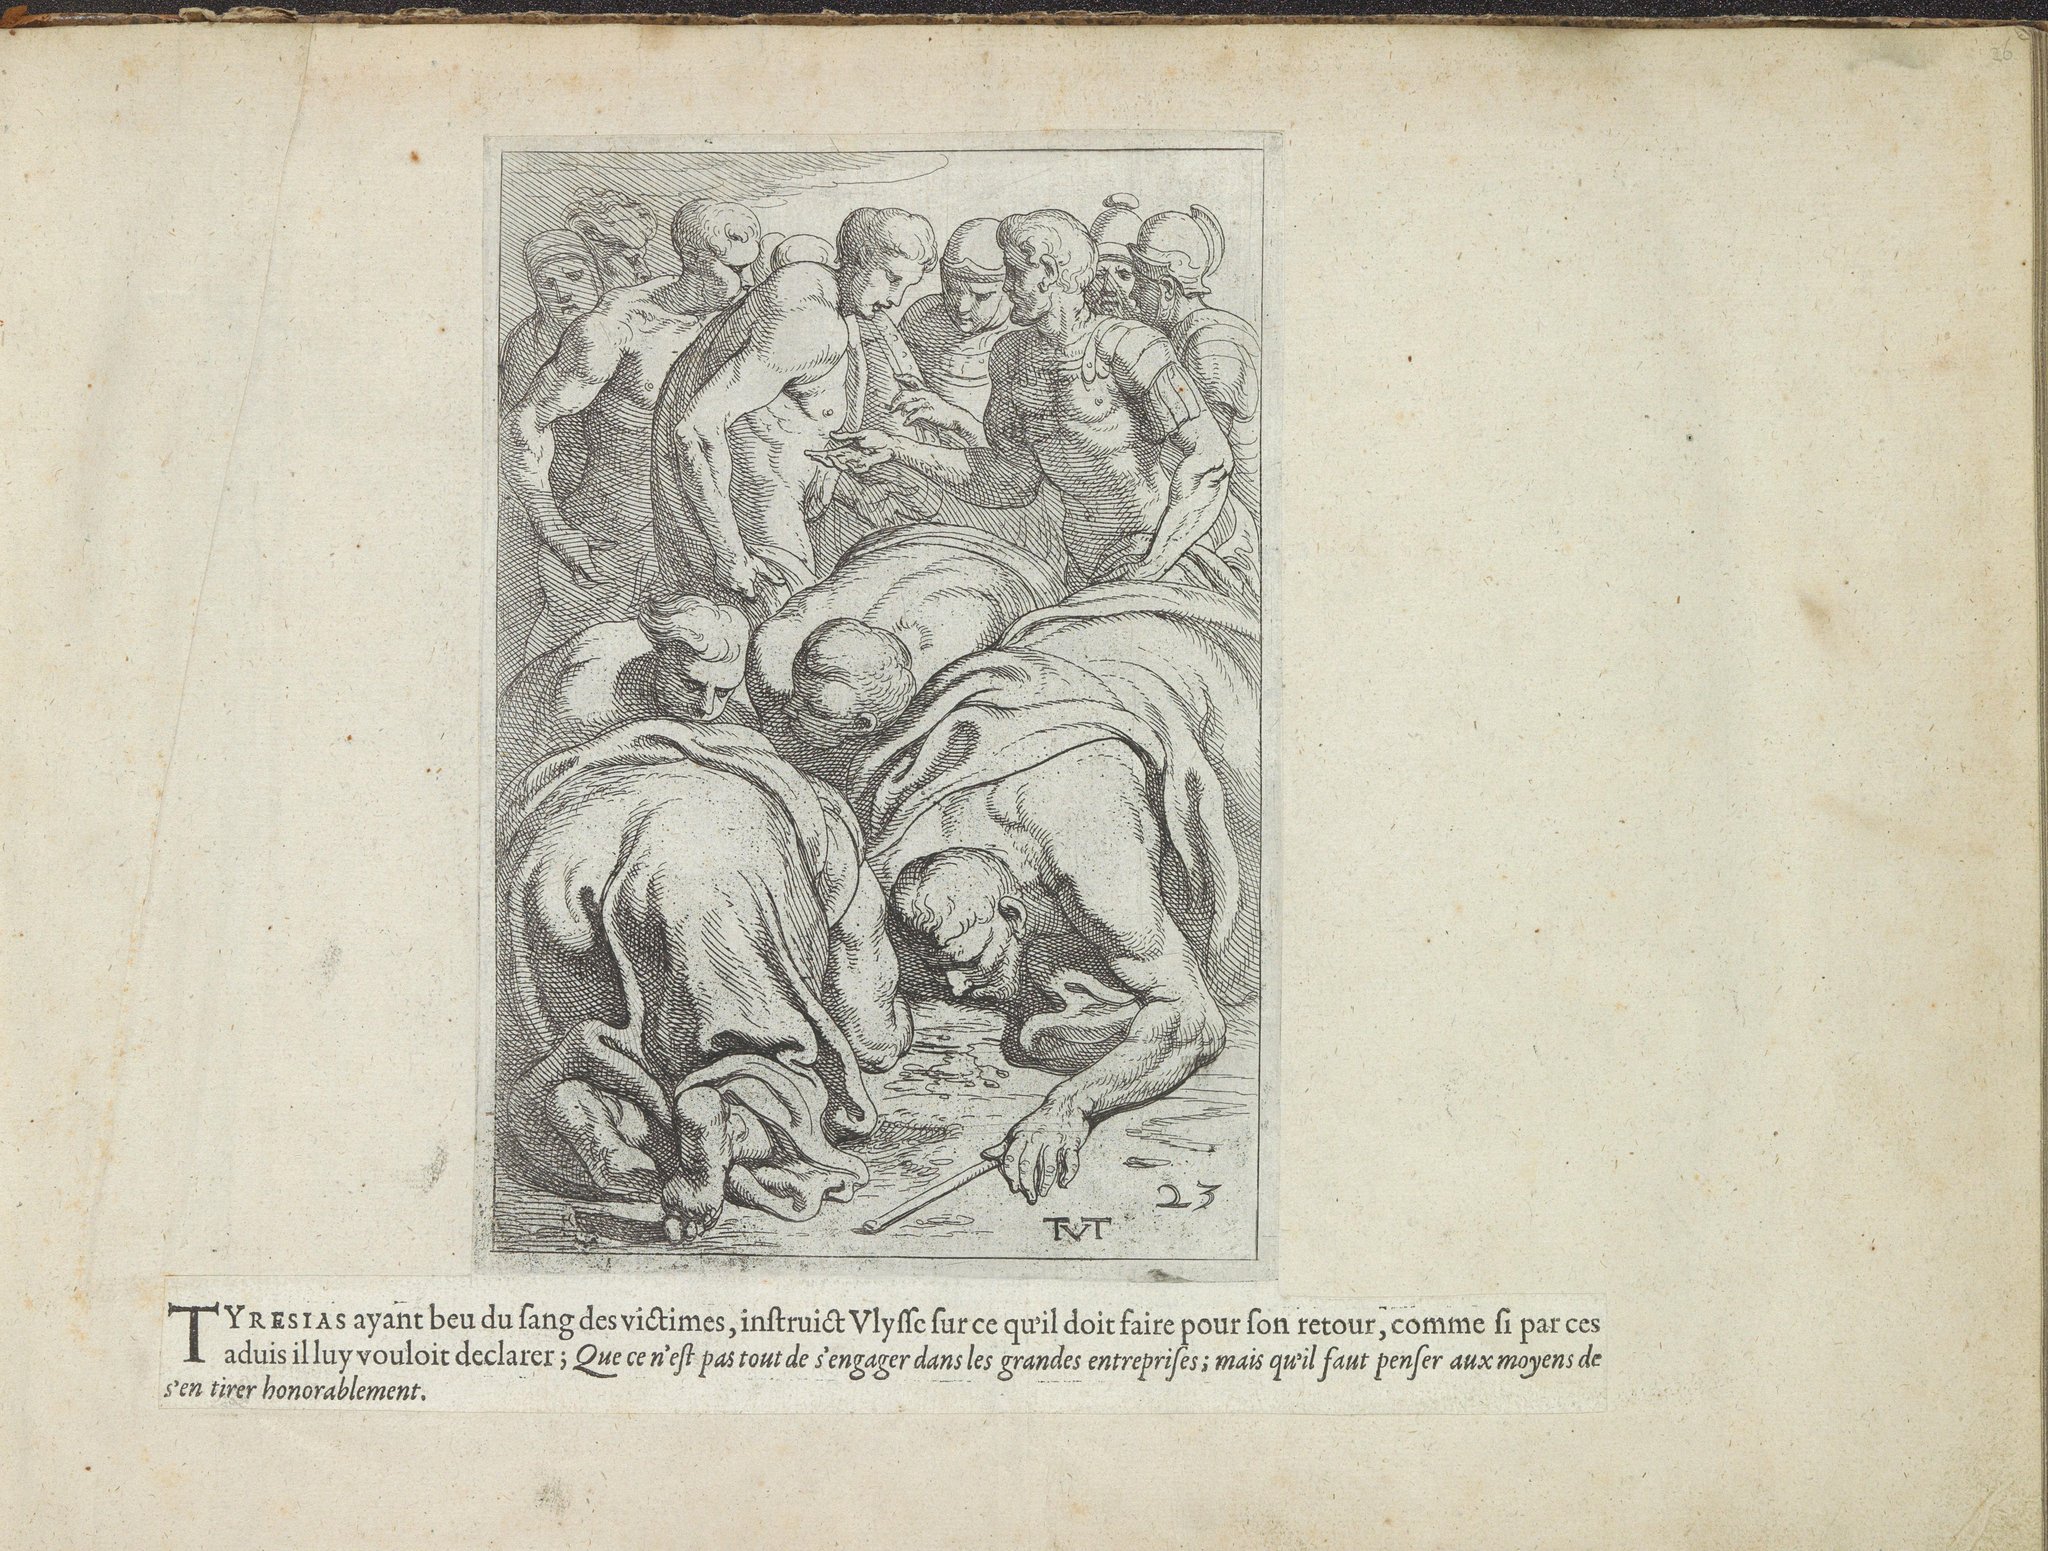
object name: album leaf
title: Les Travaux d'Ulysse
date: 1633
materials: paper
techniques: engraving, etching, letterpress printing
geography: paris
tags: ulysses and the ghost of tiresias, who tells him about the future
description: Tiresias drinkt eerst van het bloed van het offer dat Odysseus in de onderwereld gebracht heeft. Daarna drinken de andere schimmen ervan. Odysseus is op de achtergrond met een aantal mannen in gesprek. De prent maakt deel uit van een album.